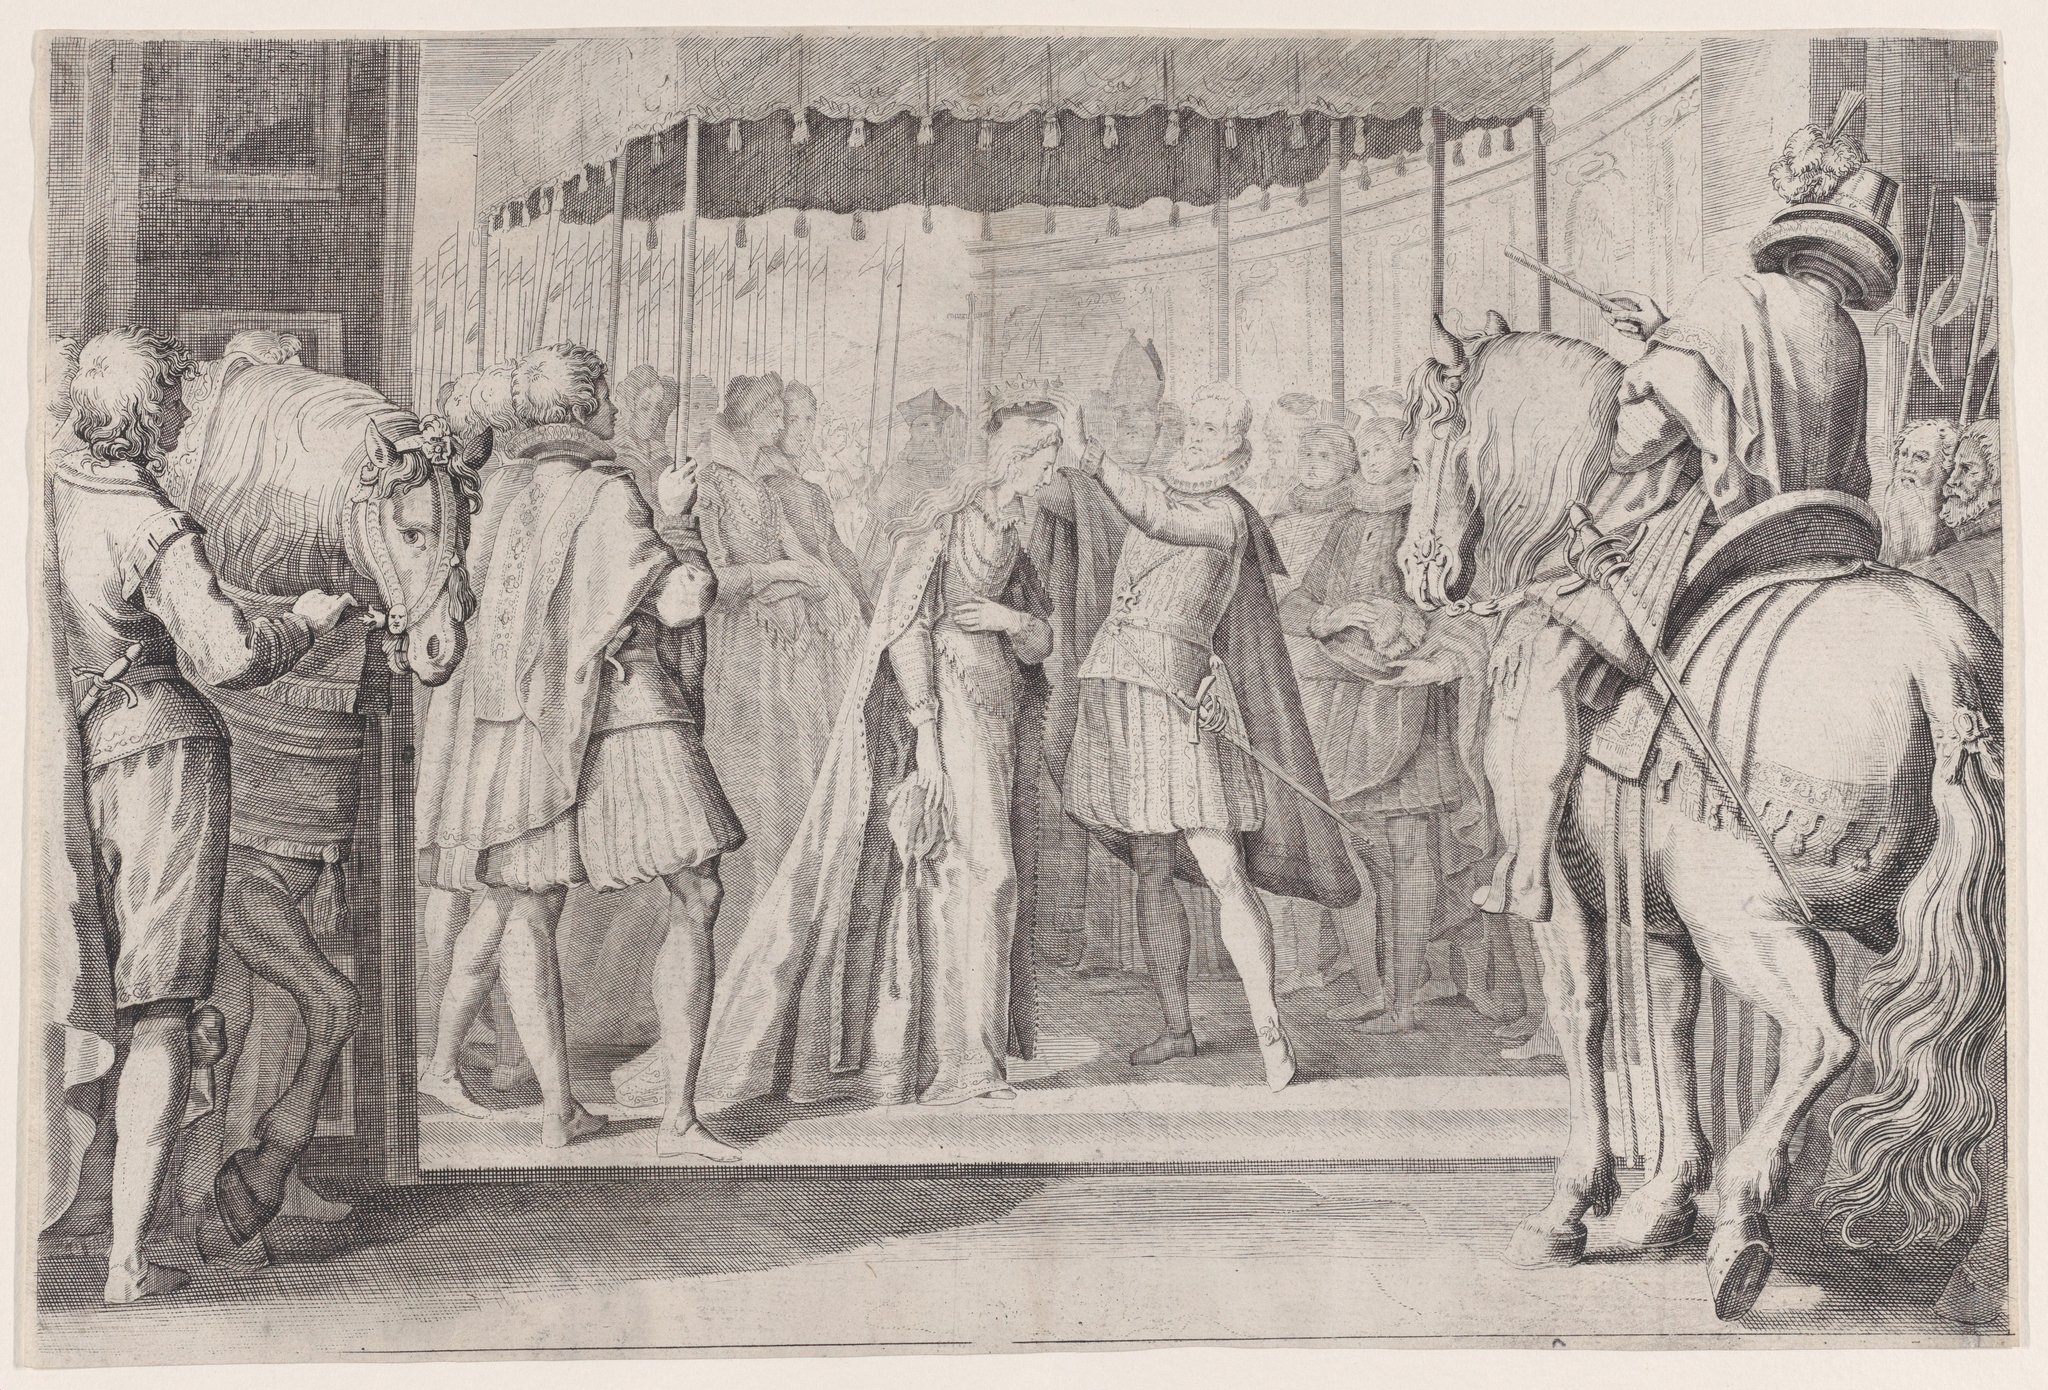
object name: print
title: Copy of Couronnement de Christine de Lorraine, la Grande Duchesse (Coronation of the Grand Duchess, Christine de Lorraine), from "La Vie de Ferdinand Ier de Médicis série appelée aussi Les Batailles des Médicis" (The Life of Ferdinand I de'Medici also called The Medici Battles)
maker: jacques callot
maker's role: artist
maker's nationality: french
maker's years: 1592-1635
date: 1614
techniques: engraving